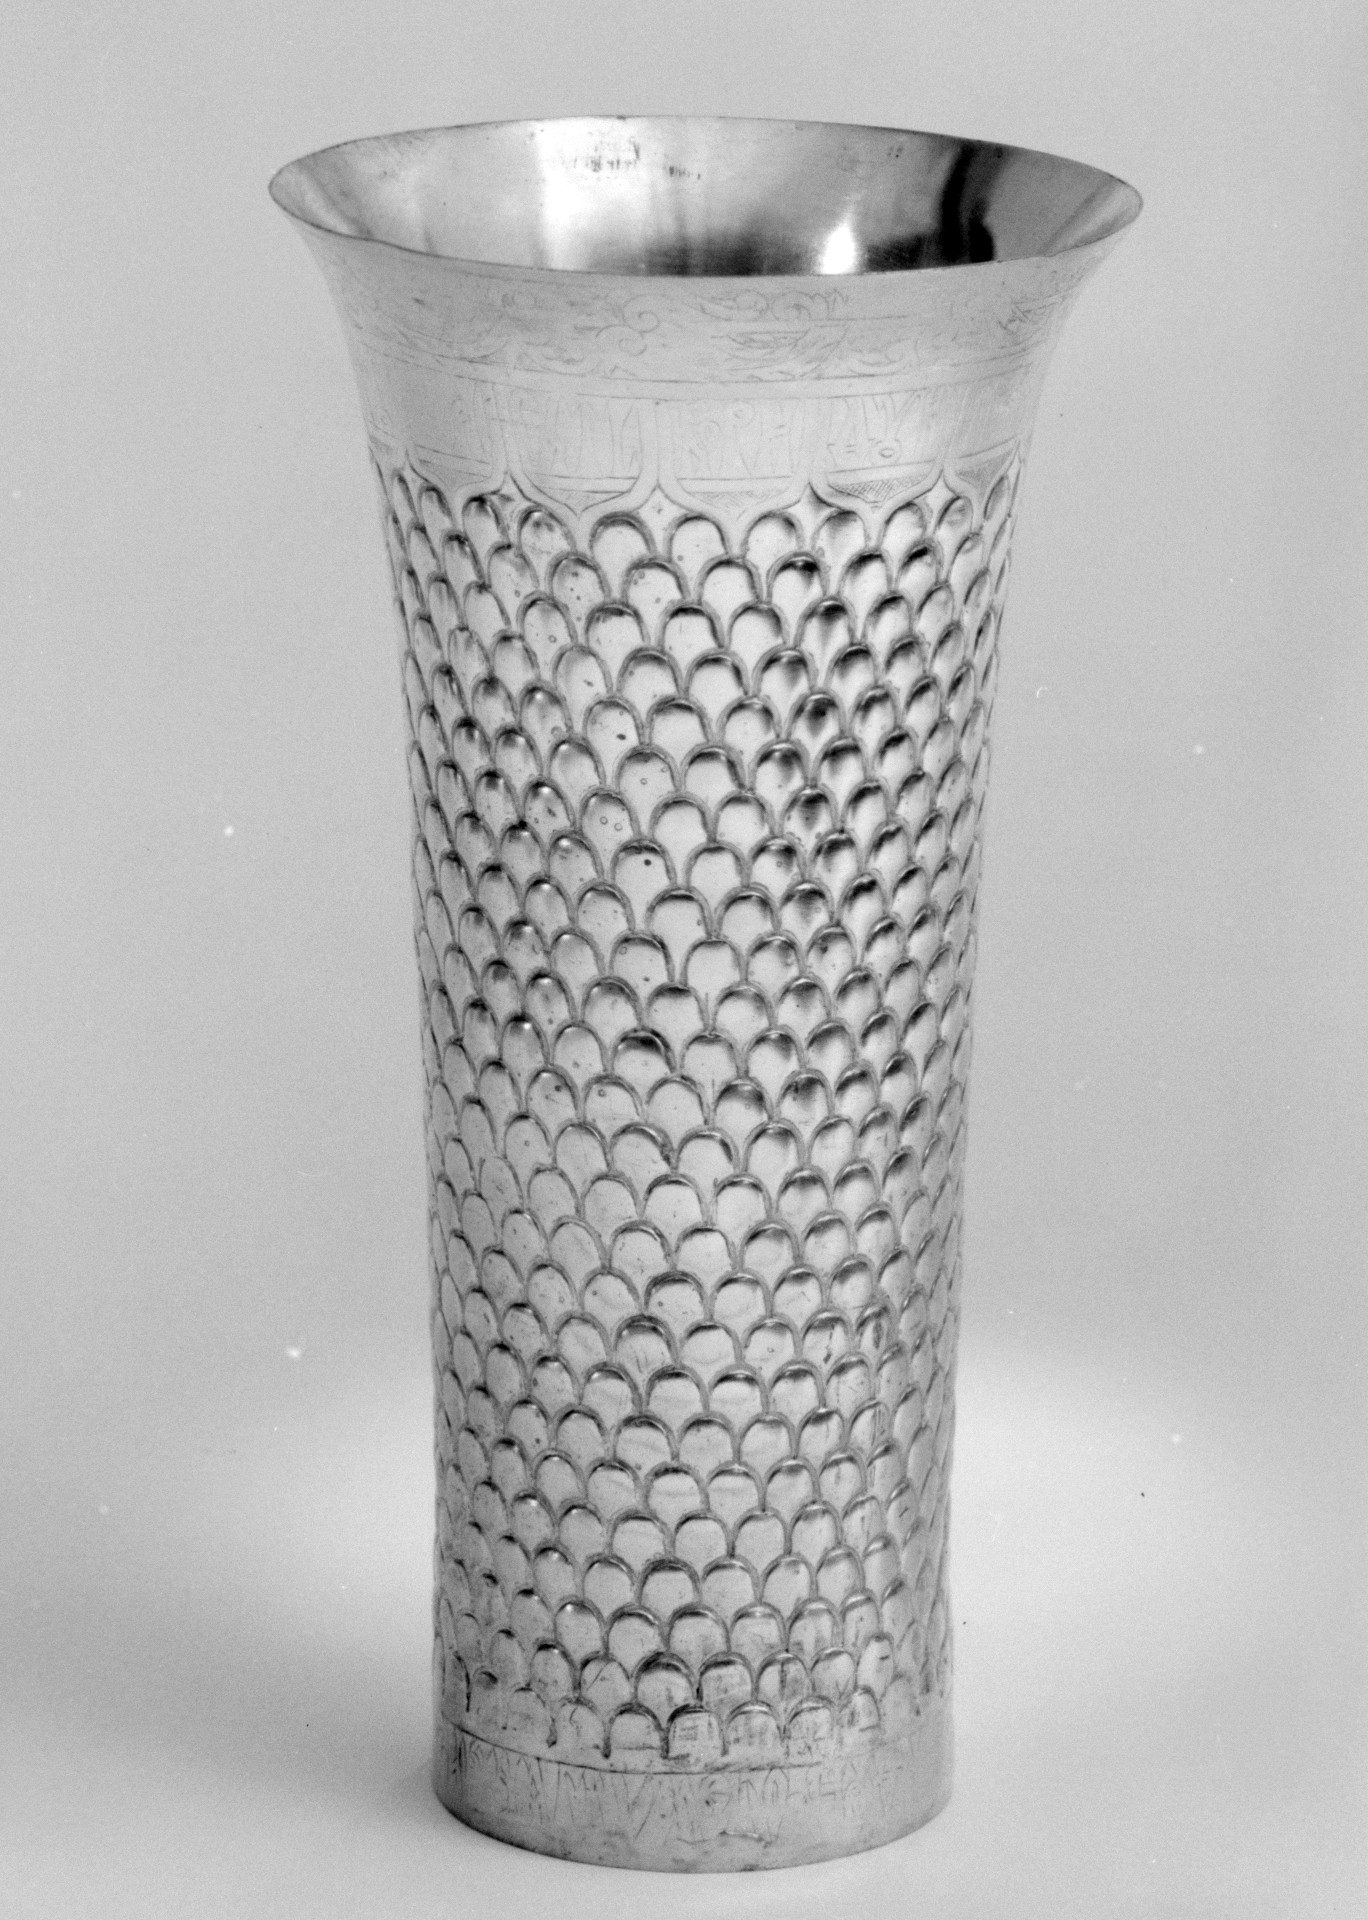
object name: beaker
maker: franchi and son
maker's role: manufacturer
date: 1801-1900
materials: gilt, silver